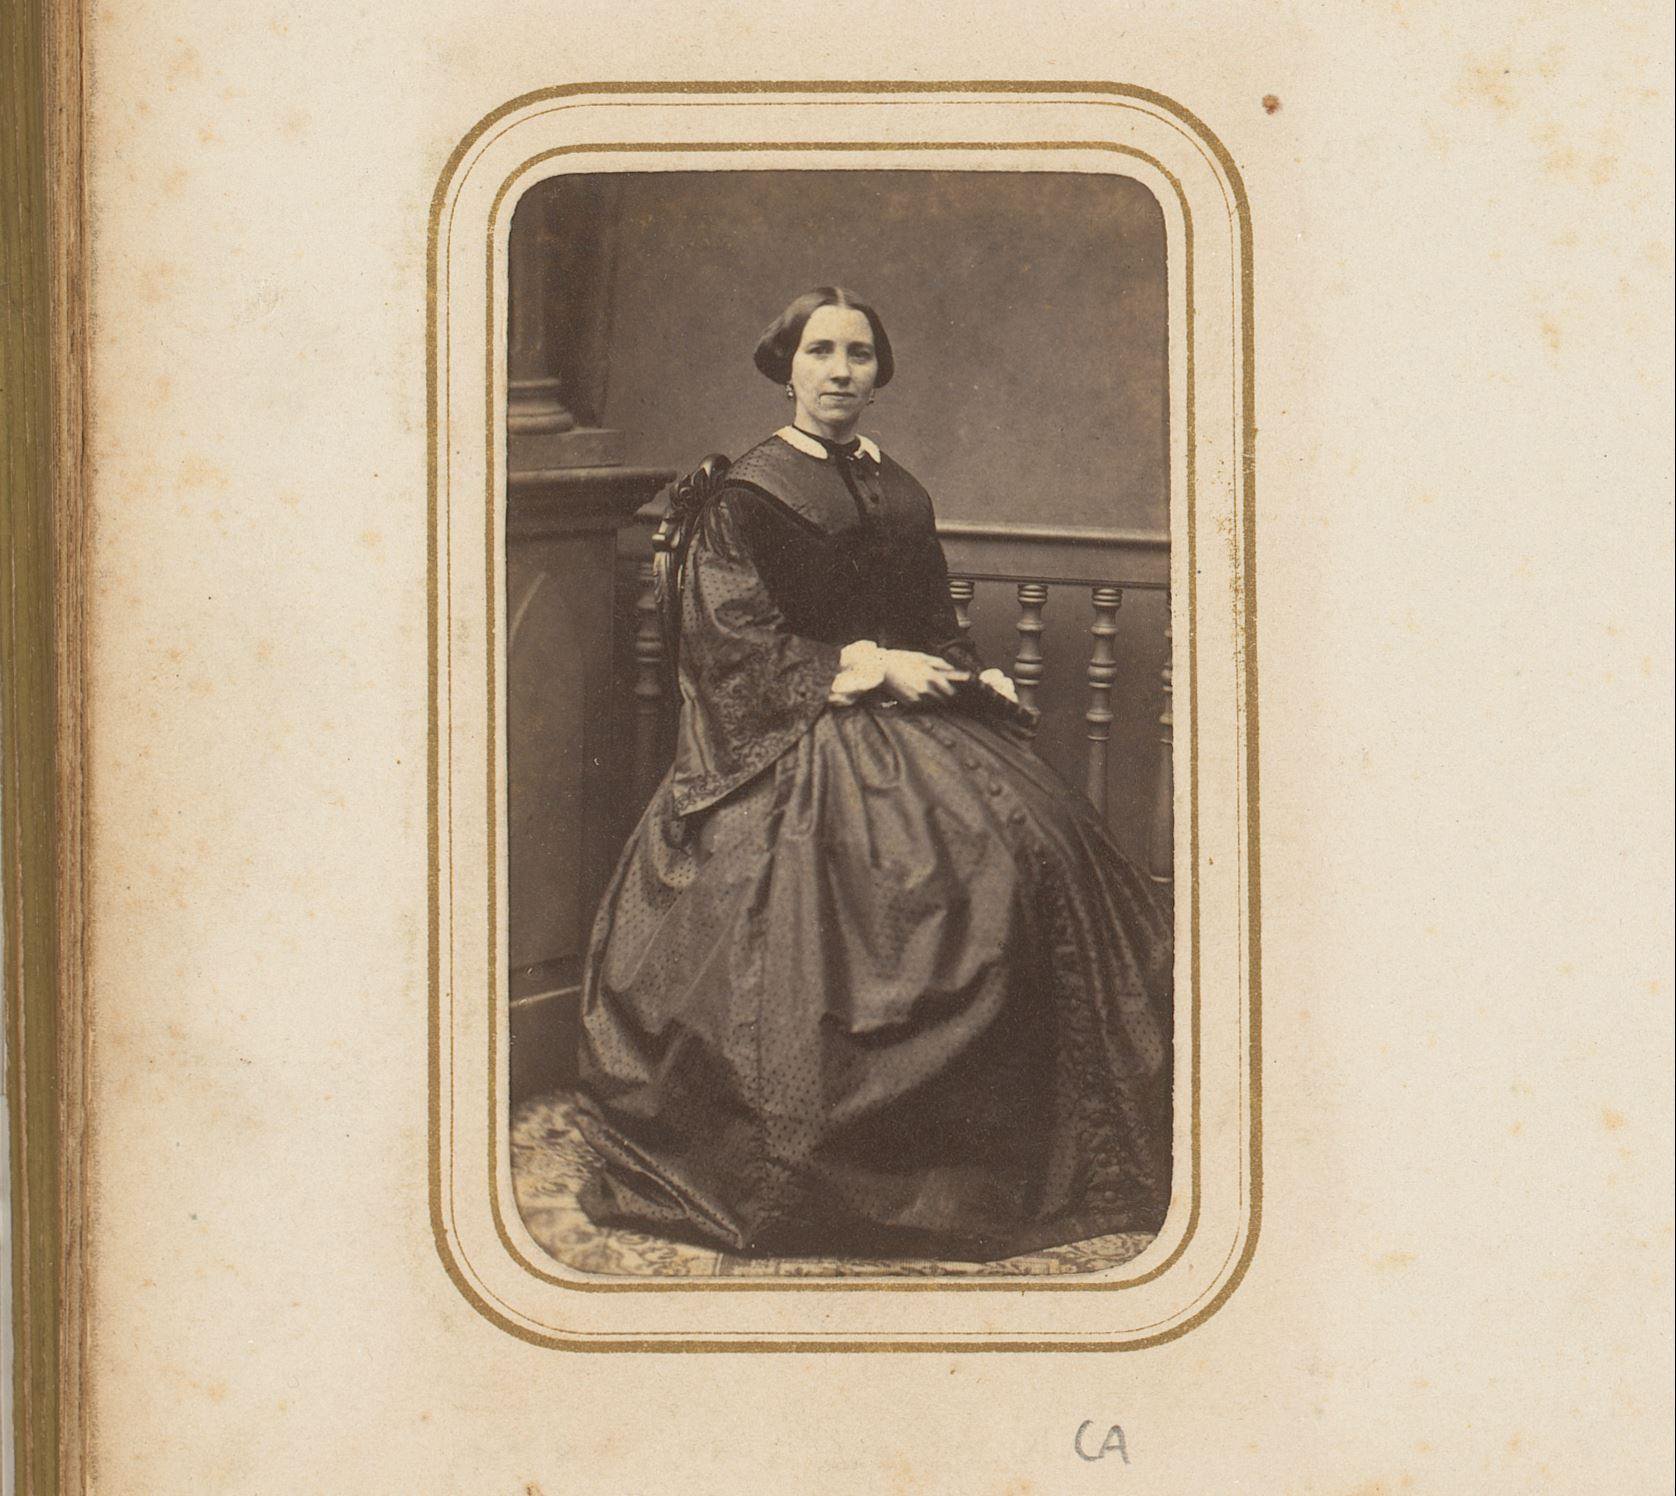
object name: album leaf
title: Portret van een zittende vrouw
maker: Anonymous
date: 1860-1890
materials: cardboard, photographic support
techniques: albumen print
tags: sitting figure - aa - female human figure, historical persons - bb - woman